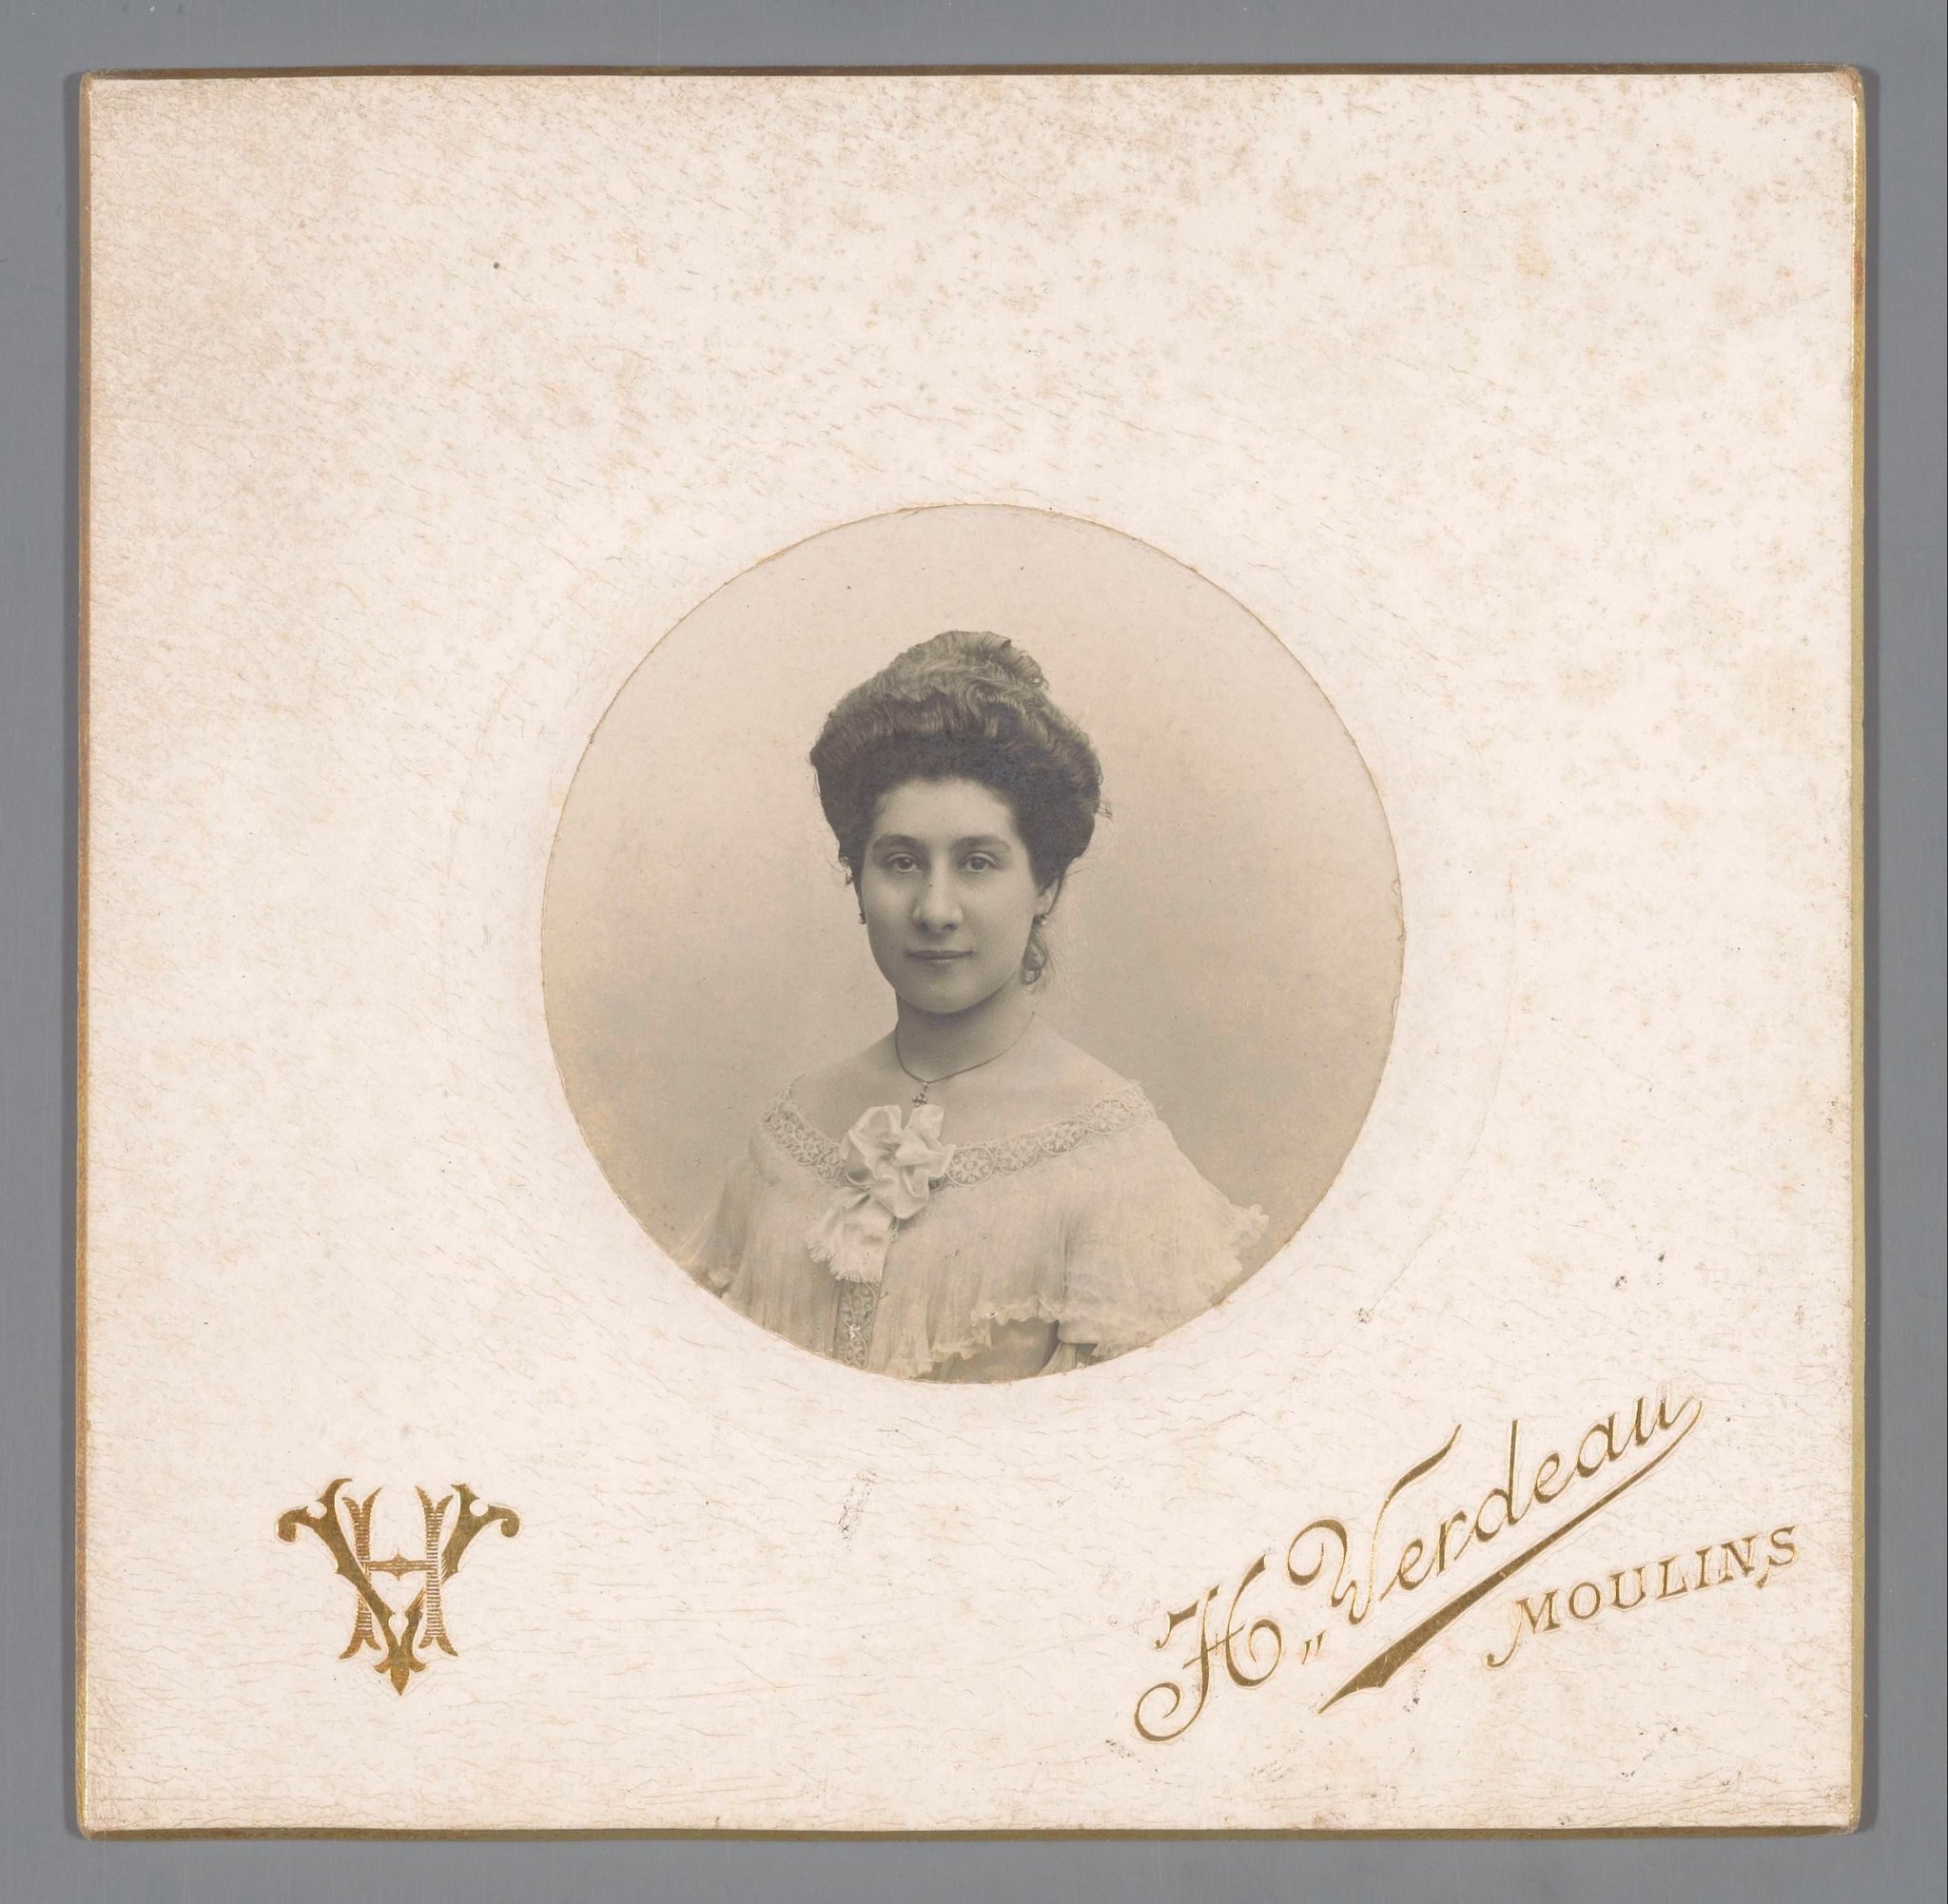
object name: photograph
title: Portret van een onbekende vrouw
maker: h. werdeau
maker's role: fotograaf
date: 1870-1910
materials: cardboard, photographic support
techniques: gelatin silver print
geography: moulins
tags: adult woman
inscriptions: inscription: ‘[...]milienie Cadot Naulint Allie’